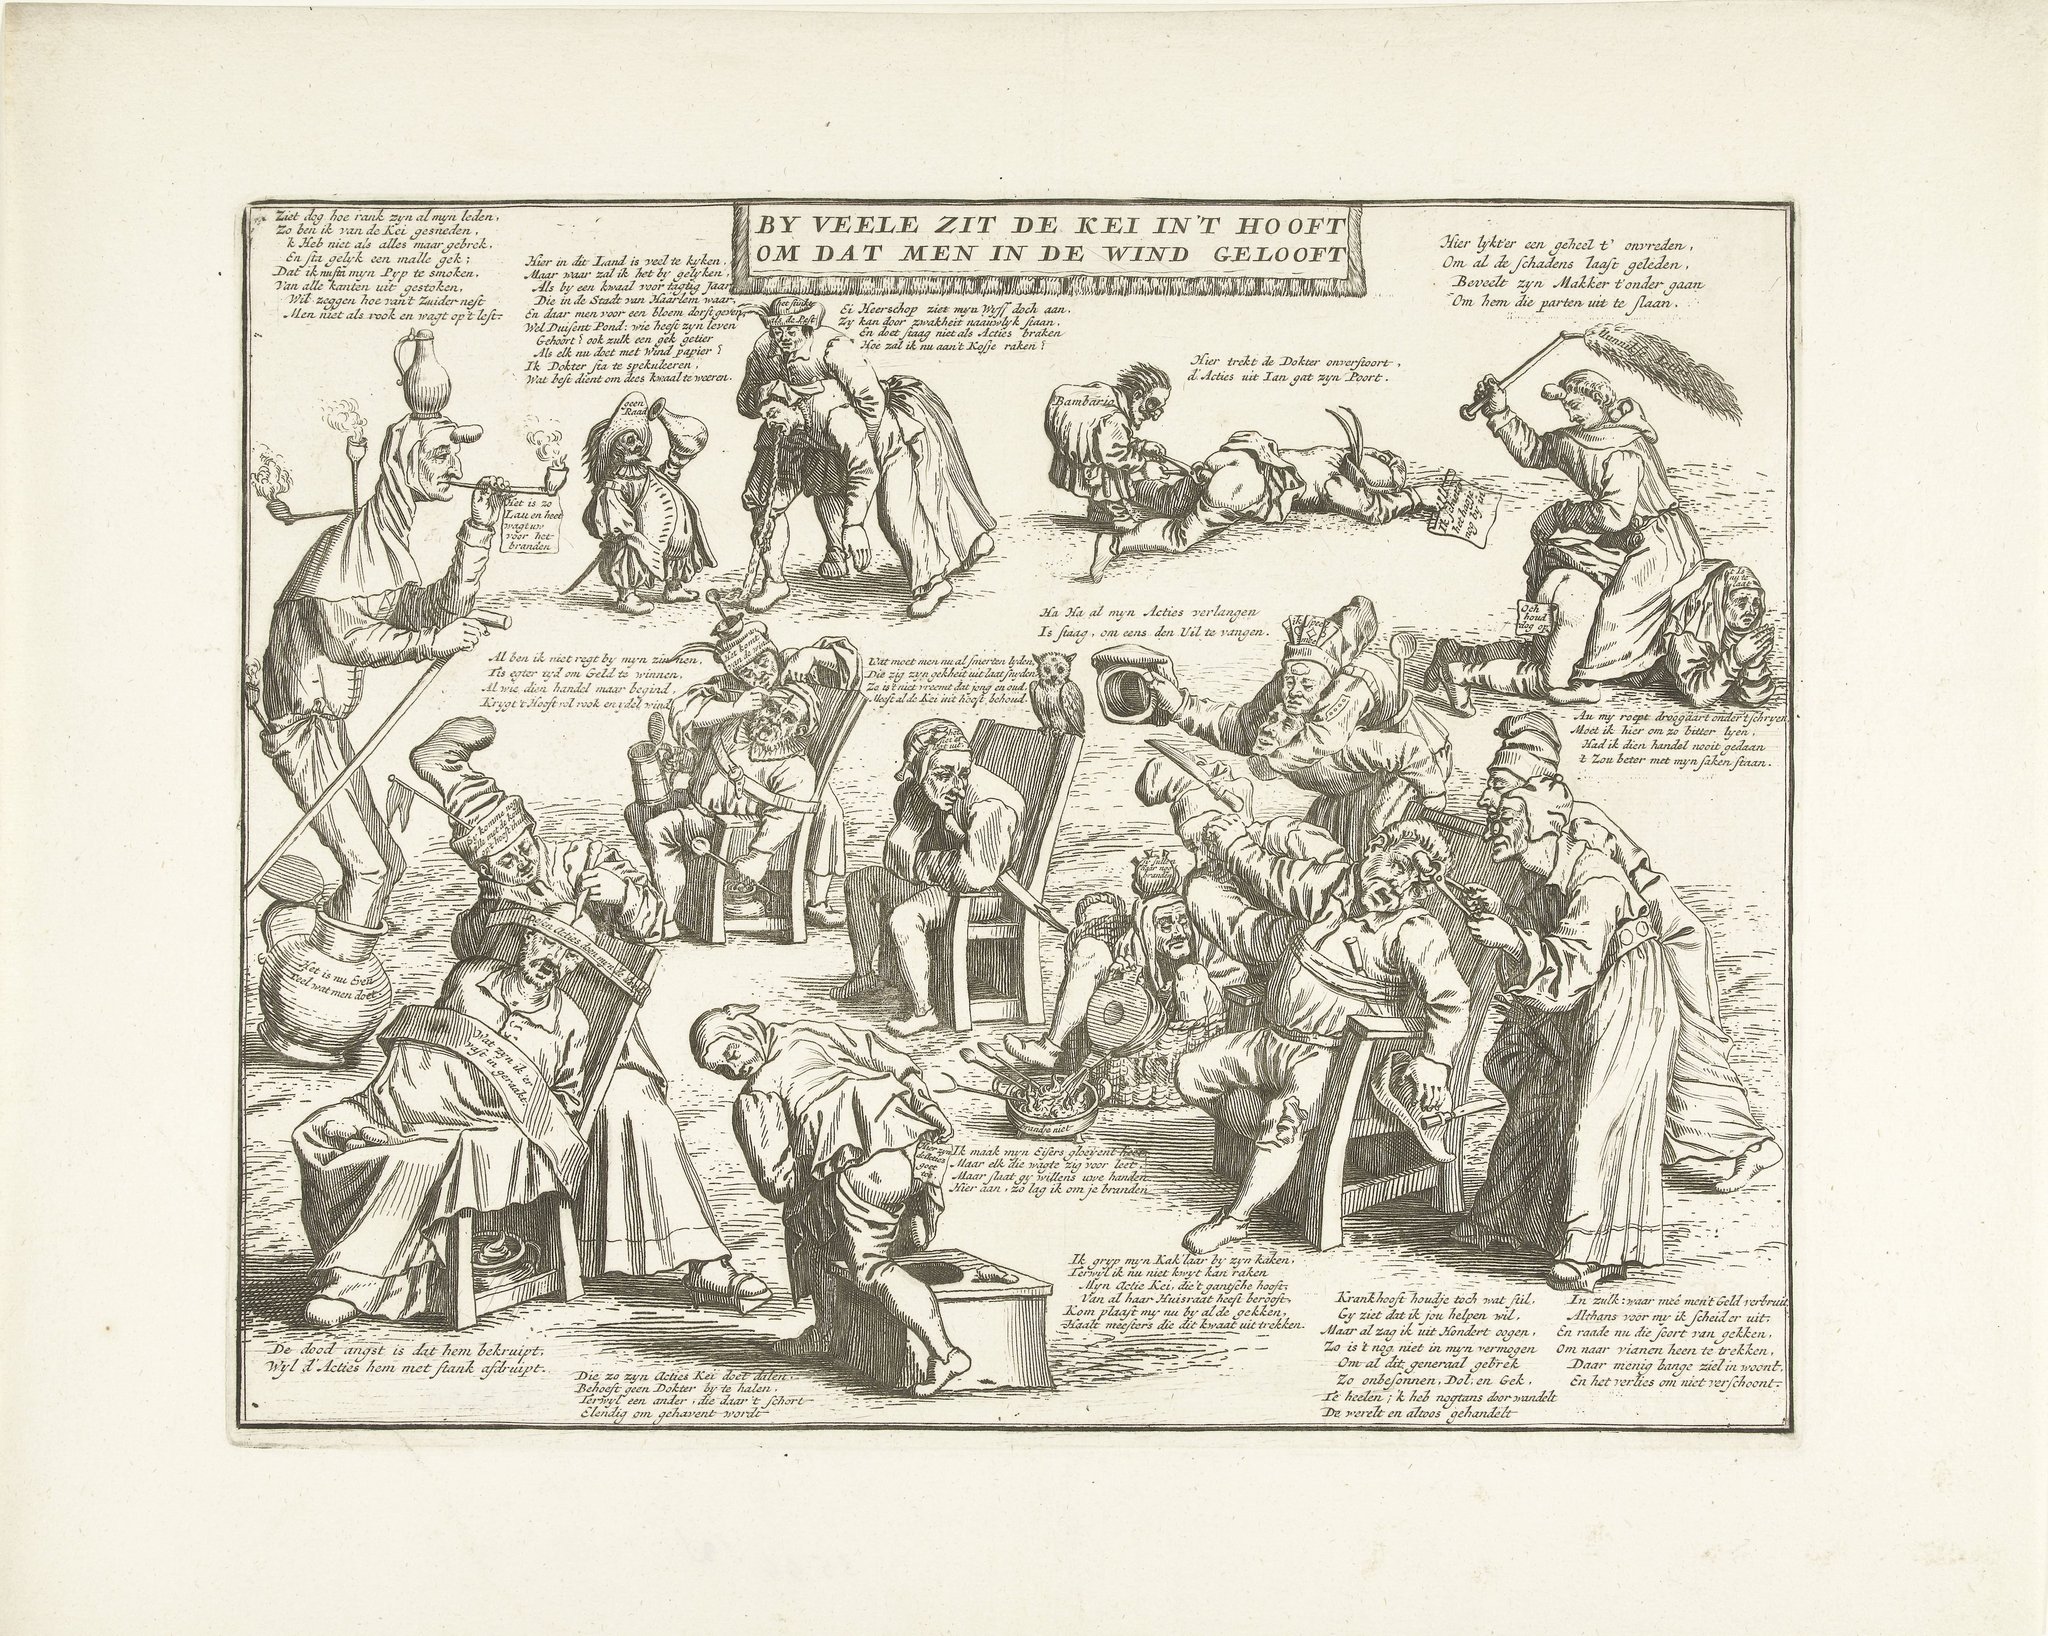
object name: print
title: By veele zit de kei in't hooft / om dat men in de wind gelooft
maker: Anonymous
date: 1720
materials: paper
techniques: etching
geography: northern netherlands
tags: dordrecht, bruges, sexual abuses of monks, stone-operation, e.g.: by the witch of malleghem, defecation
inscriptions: collector's mark: Lugt 2228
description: Spotprent op de mensen die zo dom zijn geweest om deel te nemen aan de windhandel in 1720. De slachtoffers laten kwakzalvers de kei uit hun hoofd snijden. Op de voorgrond veegt een nar zijn achterste af met een actie, bovenaan geselt een monnik (Broer Cornelis) de billen een non, ook met verschillende kleine mensen en dwazen. Veel beeldelementen ontleend aan oudere prenten. Bij alle details staan opschriften in het Nederlands. Prent 9 in de serie Het Groote Tafereel der Dwaasheid met spotprenten op de Windhandel of Actiehandel van 1720.